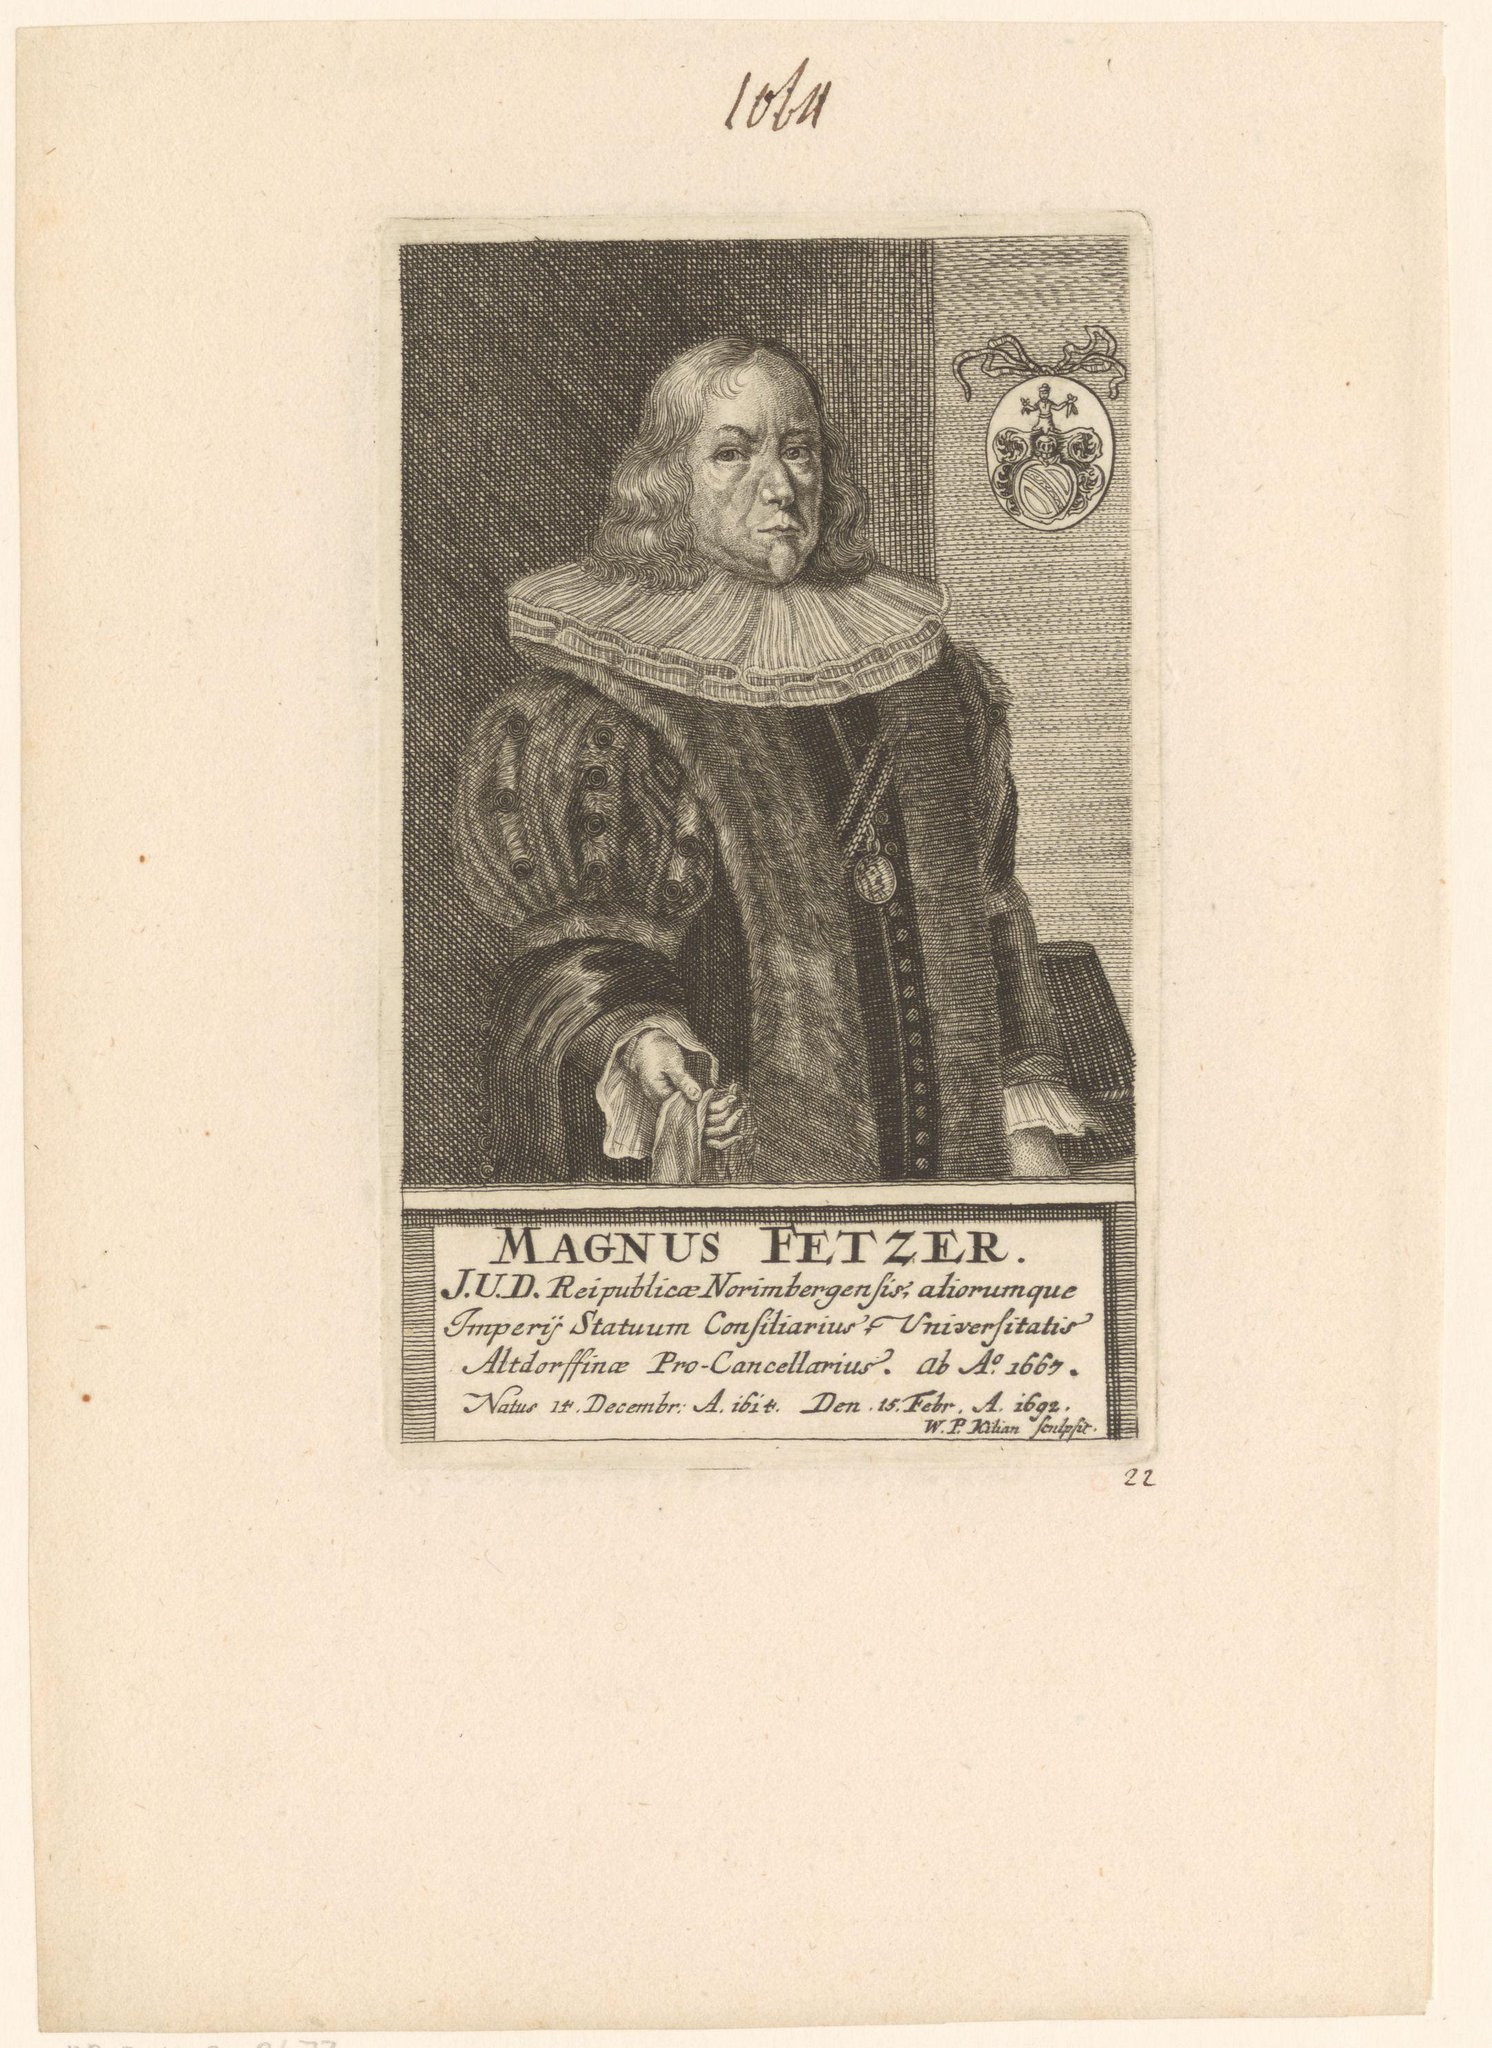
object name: print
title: Portret van Johann Fetzer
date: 1692-1732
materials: paper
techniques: engraving, etching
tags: historical persons, lawyer, attorney at law, counsellor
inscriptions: number: ‘22’, collector's mark: Lugt 2228